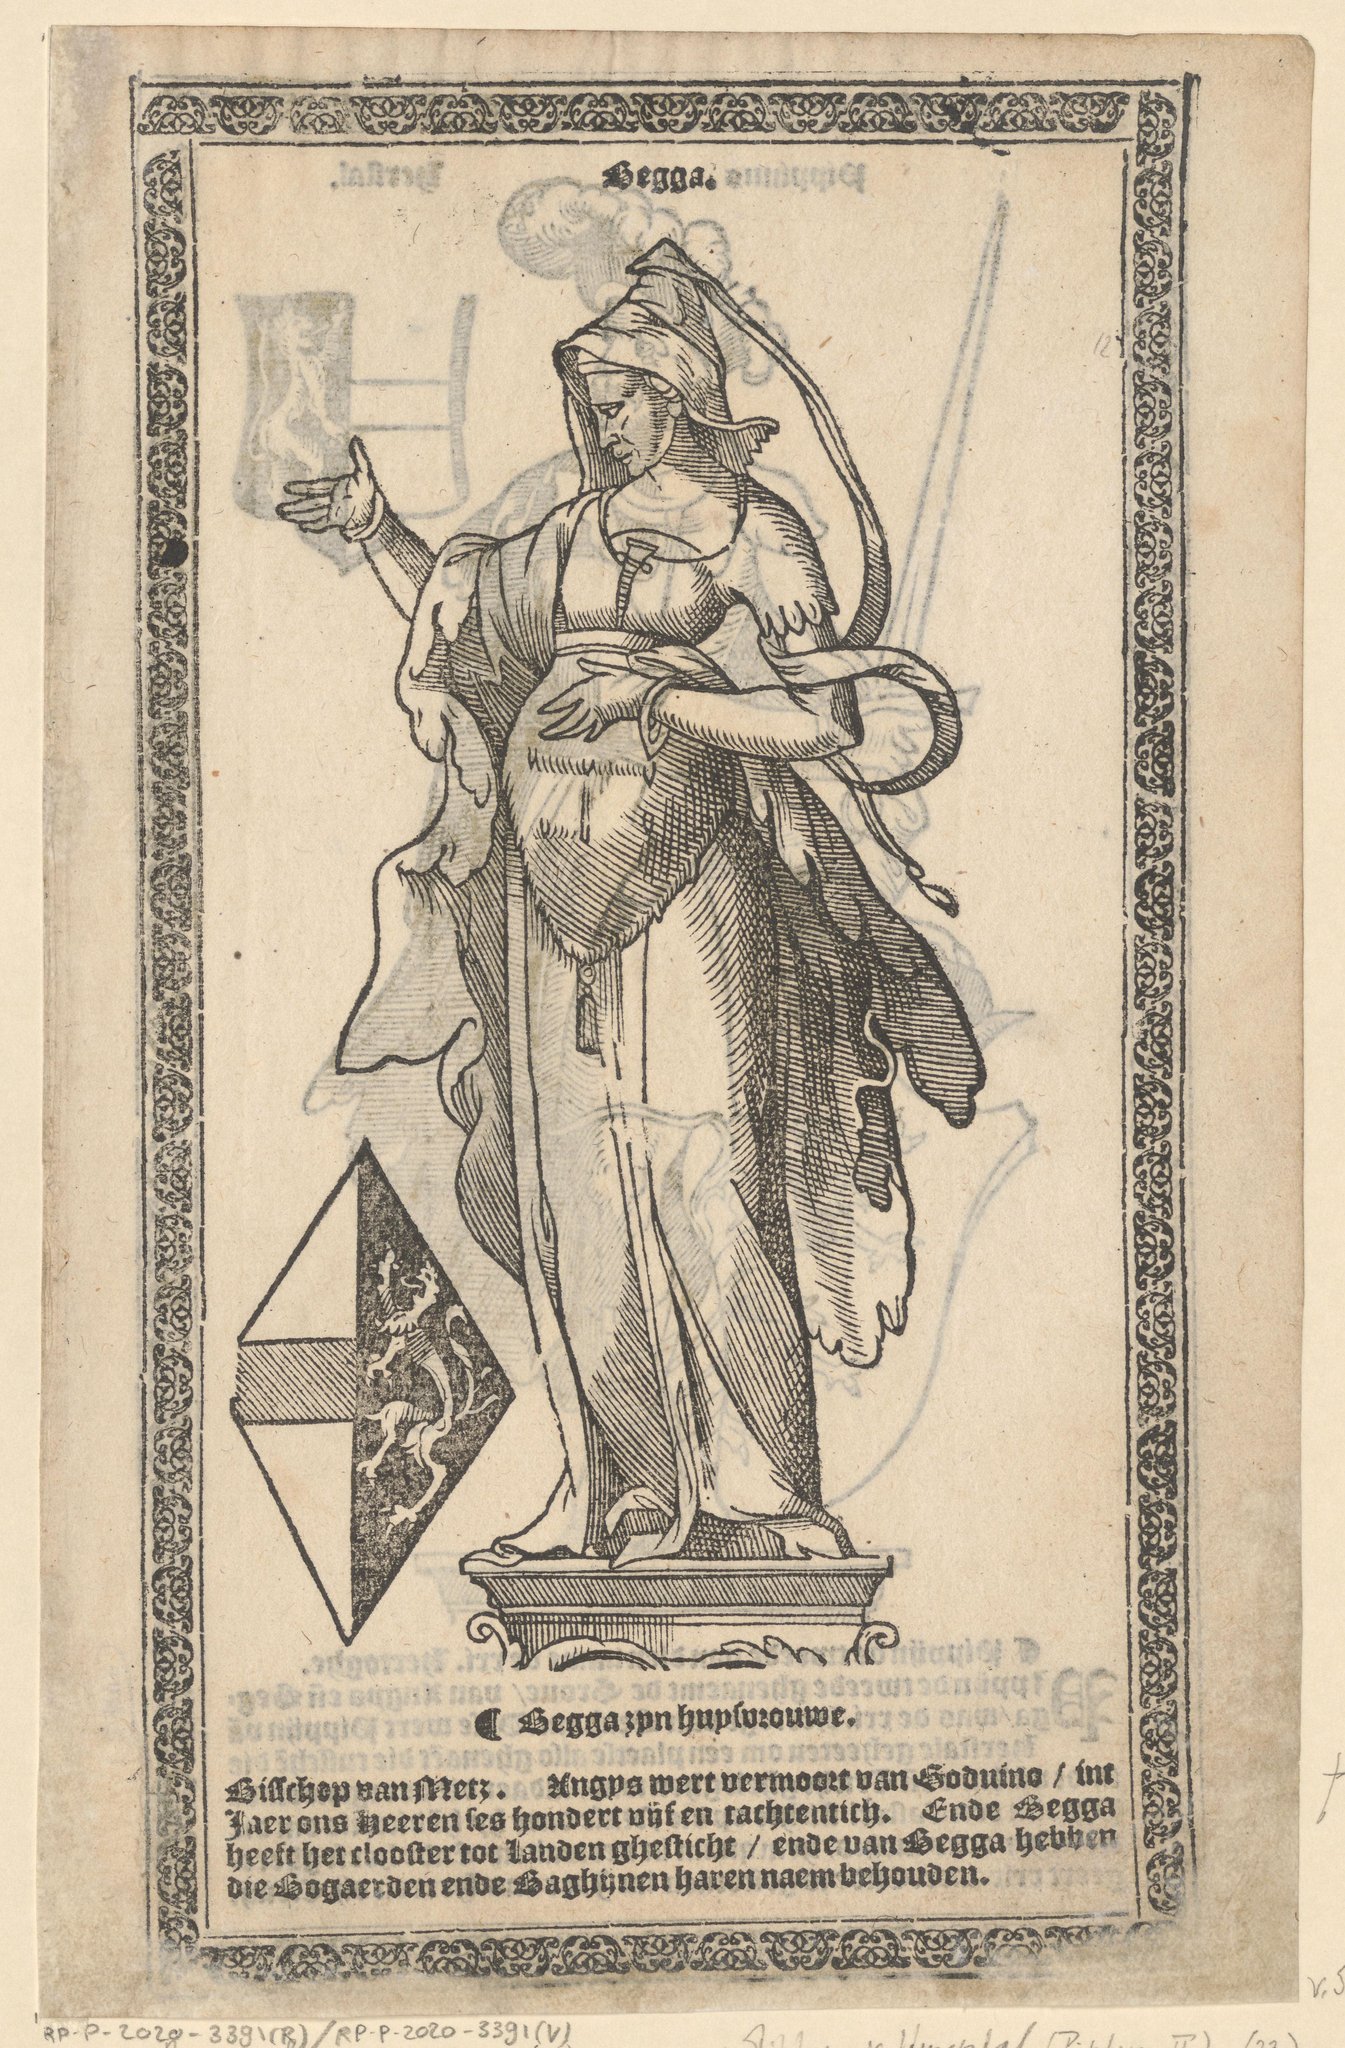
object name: book illustration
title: Portret van Begga van Landen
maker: jan molijns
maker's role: print maker, publisher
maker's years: 1498-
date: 1565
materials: paper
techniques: letterpress printing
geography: antwerp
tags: historical persons - bb - woman, armorial bearing, heraldry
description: Prent uit: Dit is die afcoemste ende genalogie der hertoghen ende hertoginnen van Brabandt, (...). Antwerpen: Jan Molijns, 1565.